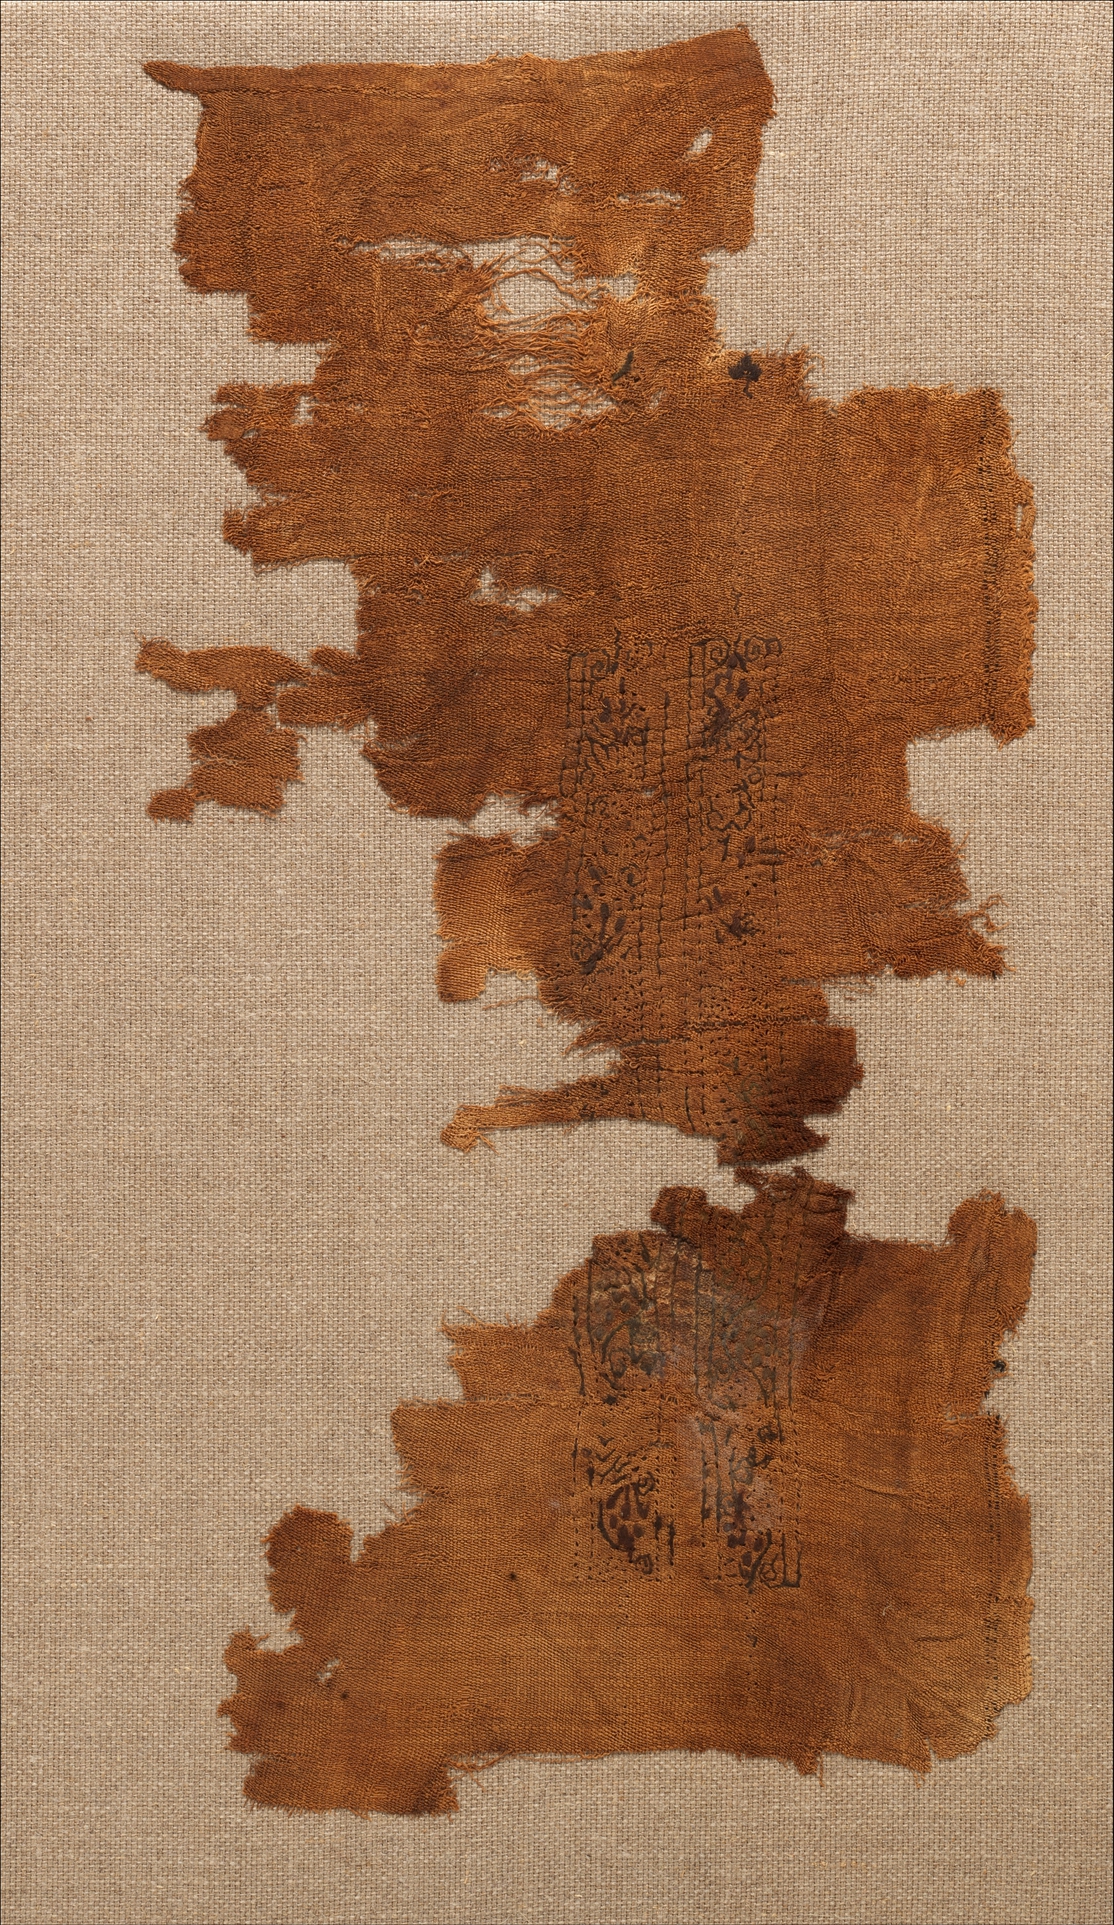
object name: fragment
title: Dress Fragments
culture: coptic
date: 301-400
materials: linen, wool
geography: egypt